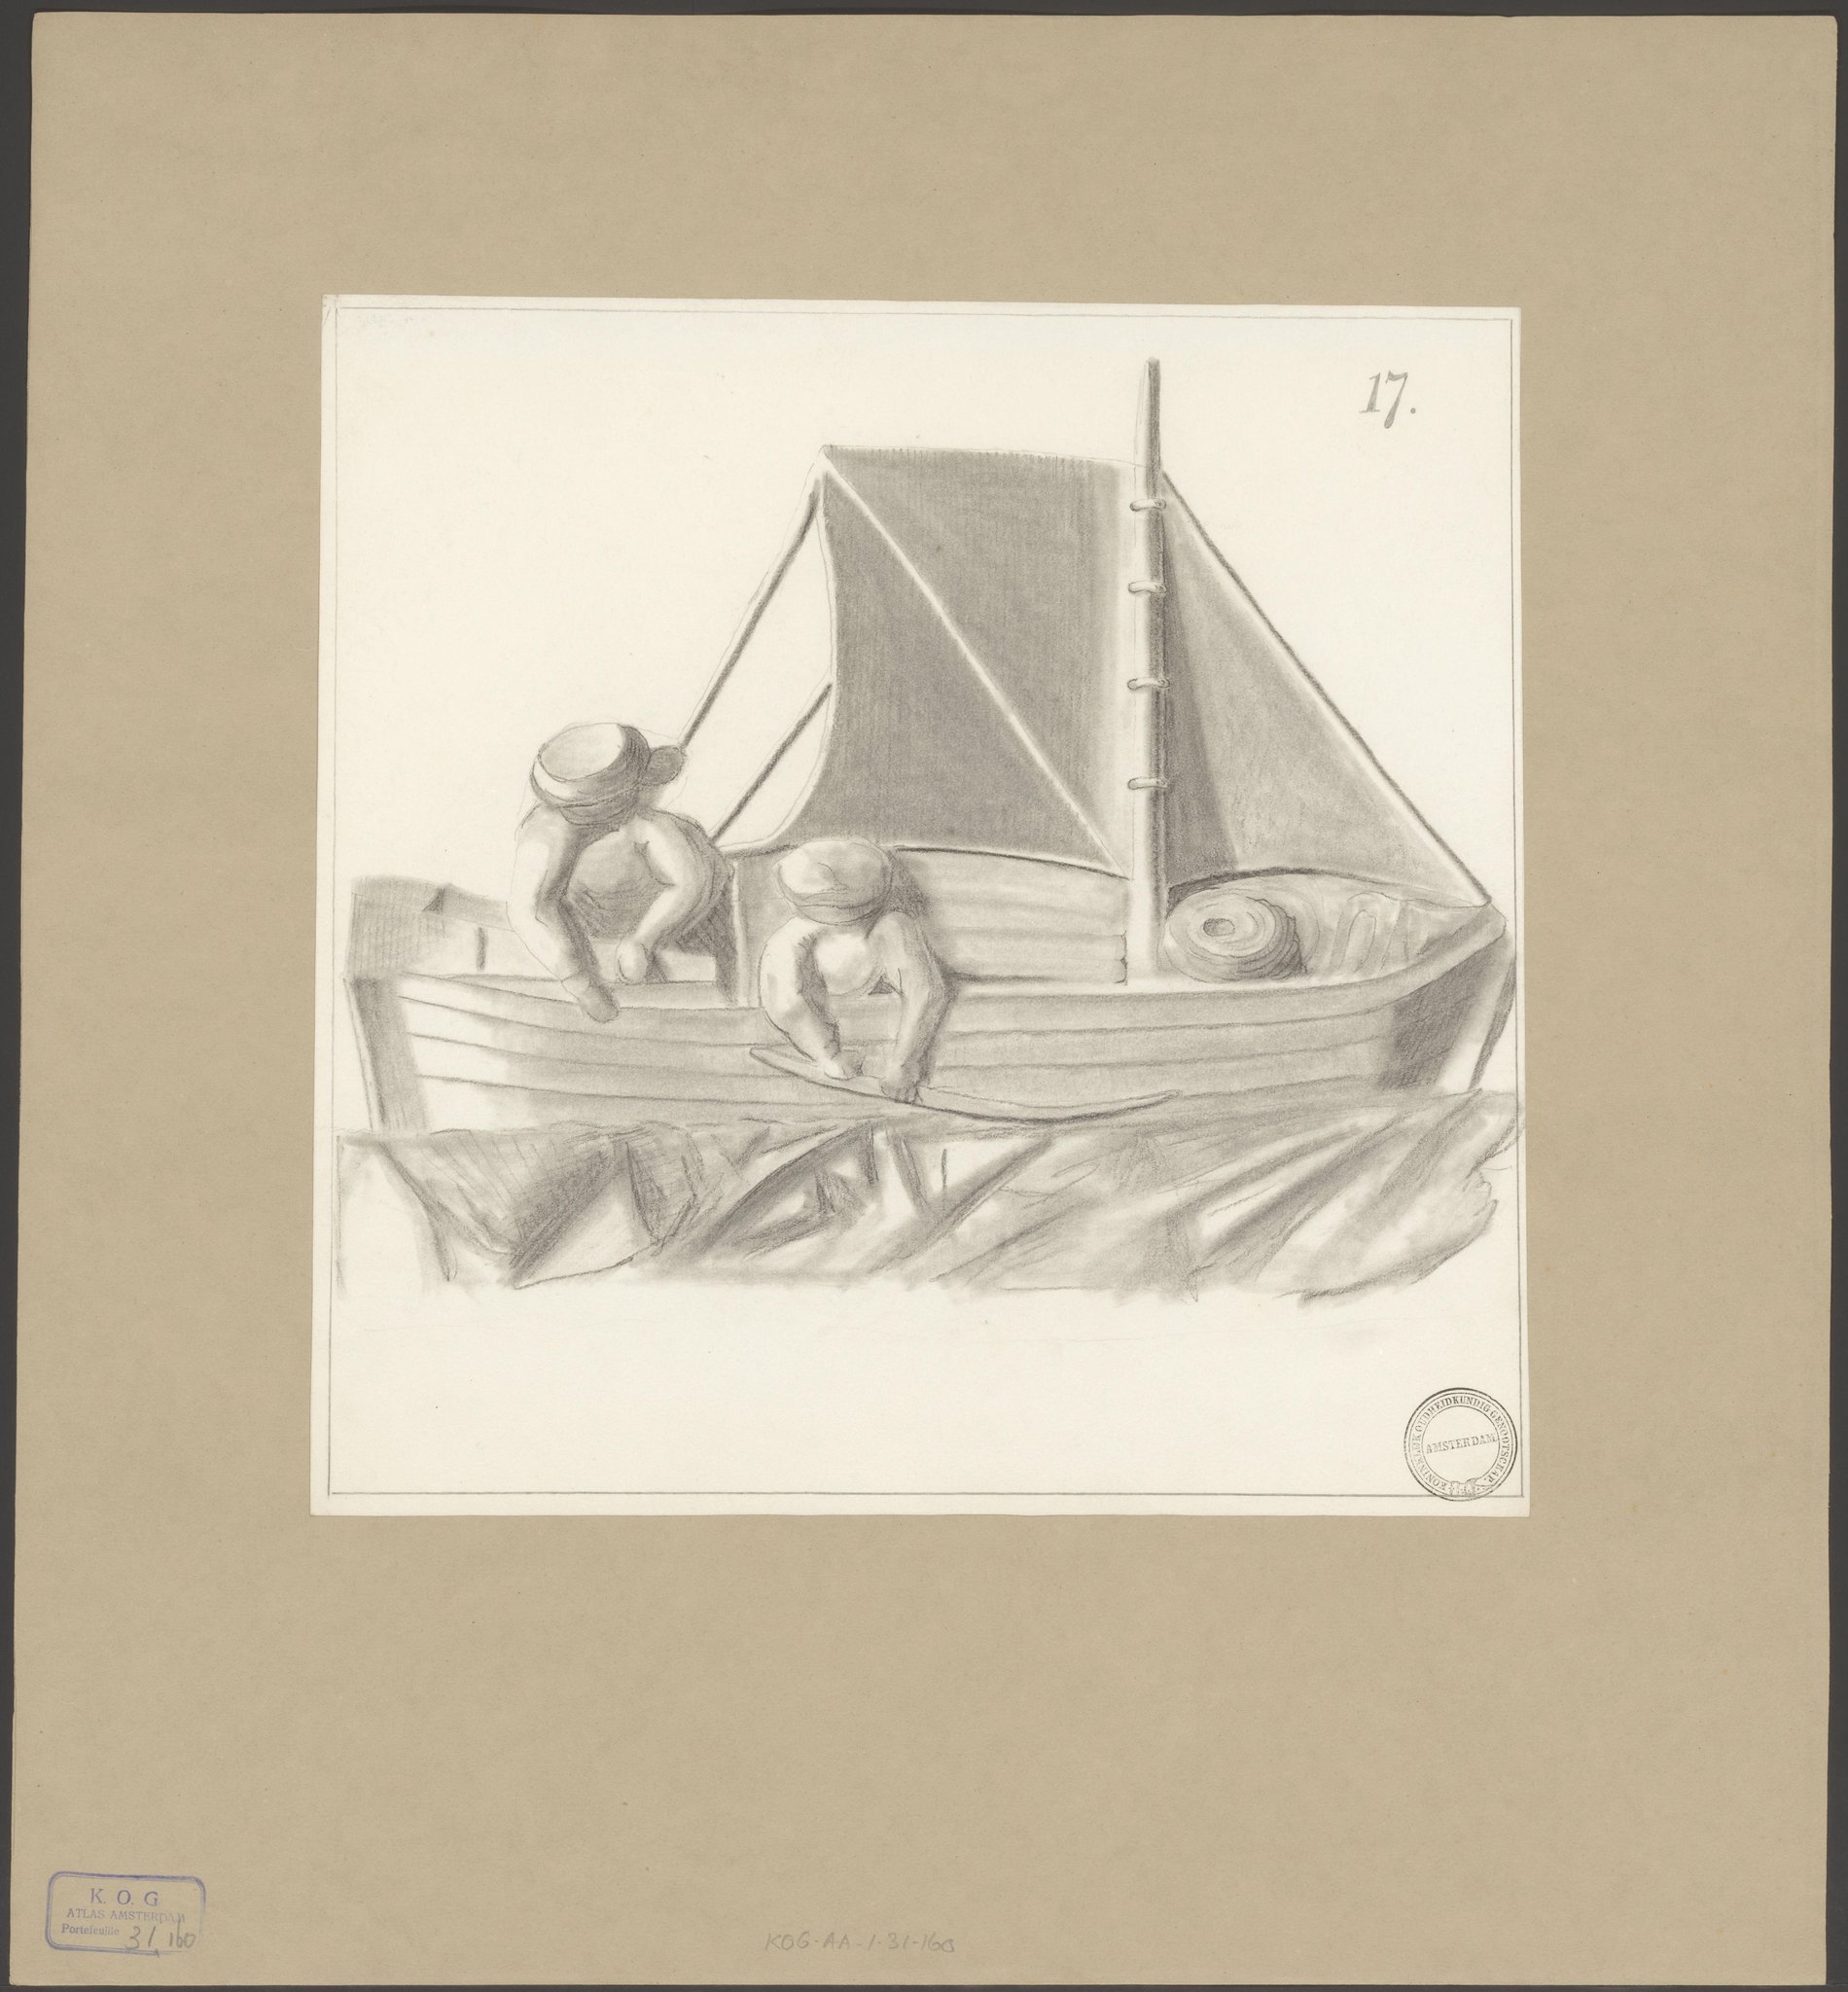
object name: print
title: Misericorde met twee figuren in een schip in de Oude Kerk te Amsterdam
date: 1880-1929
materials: paper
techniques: lithograph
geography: amsterdam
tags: misericords, tow-boat, towing-barge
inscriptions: collector's mark: ‘Koninklijk Oudheidkundig Genootschap / Amsterdam’, collector's mark: ‘31,160’ Lugt 1641b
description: Rechtsboven genummerd: 17. Onderwerpsrubriek binnen de Atlas Amsterdam: Kerkwezen: Hervormde Gemeente: Oude Kerk, koorgestoelte.